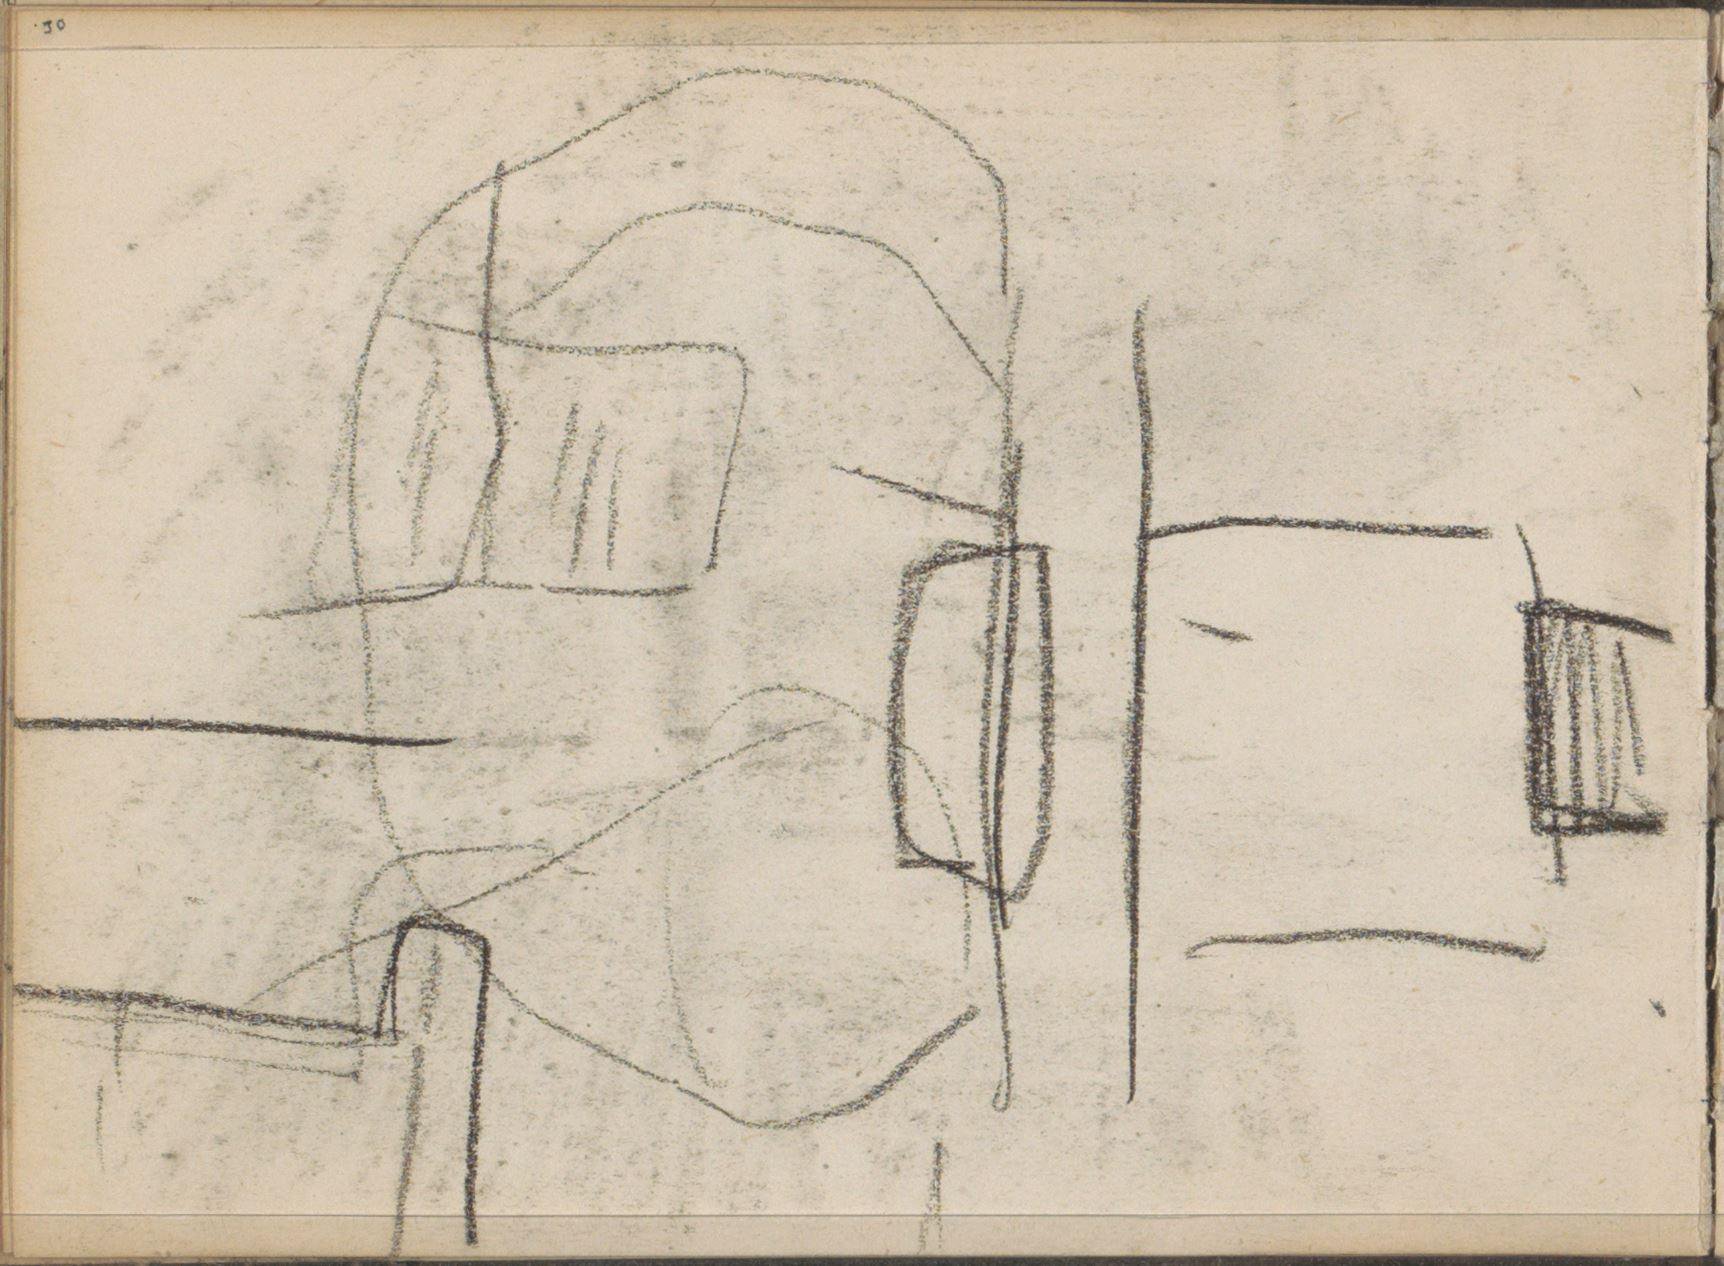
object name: sketchbook leaf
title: Studie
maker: marius bauer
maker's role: draughtsman, print maker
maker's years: 1867-1932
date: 1877-1932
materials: chalk, paper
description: Pagina 30 uit een schetsboek met 32 bladen.